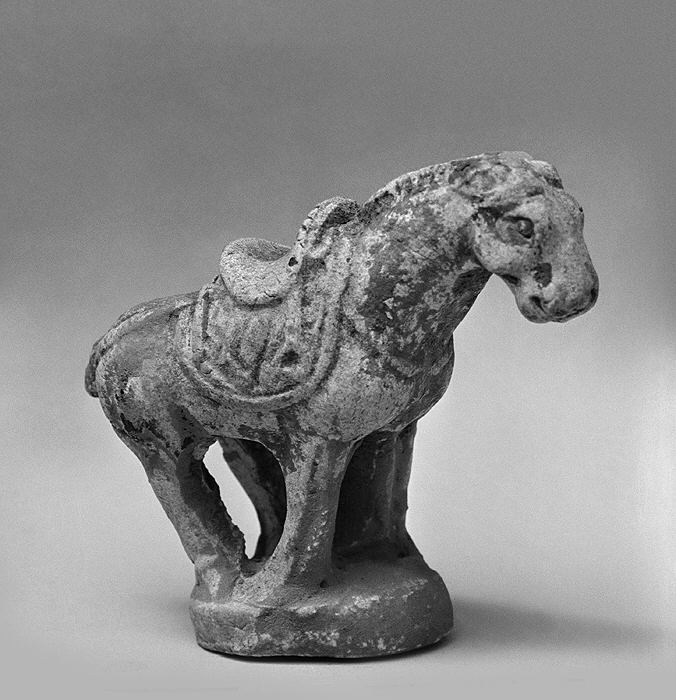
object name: figure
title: Horse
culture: chinese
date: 601-900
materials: earthenware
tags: horses